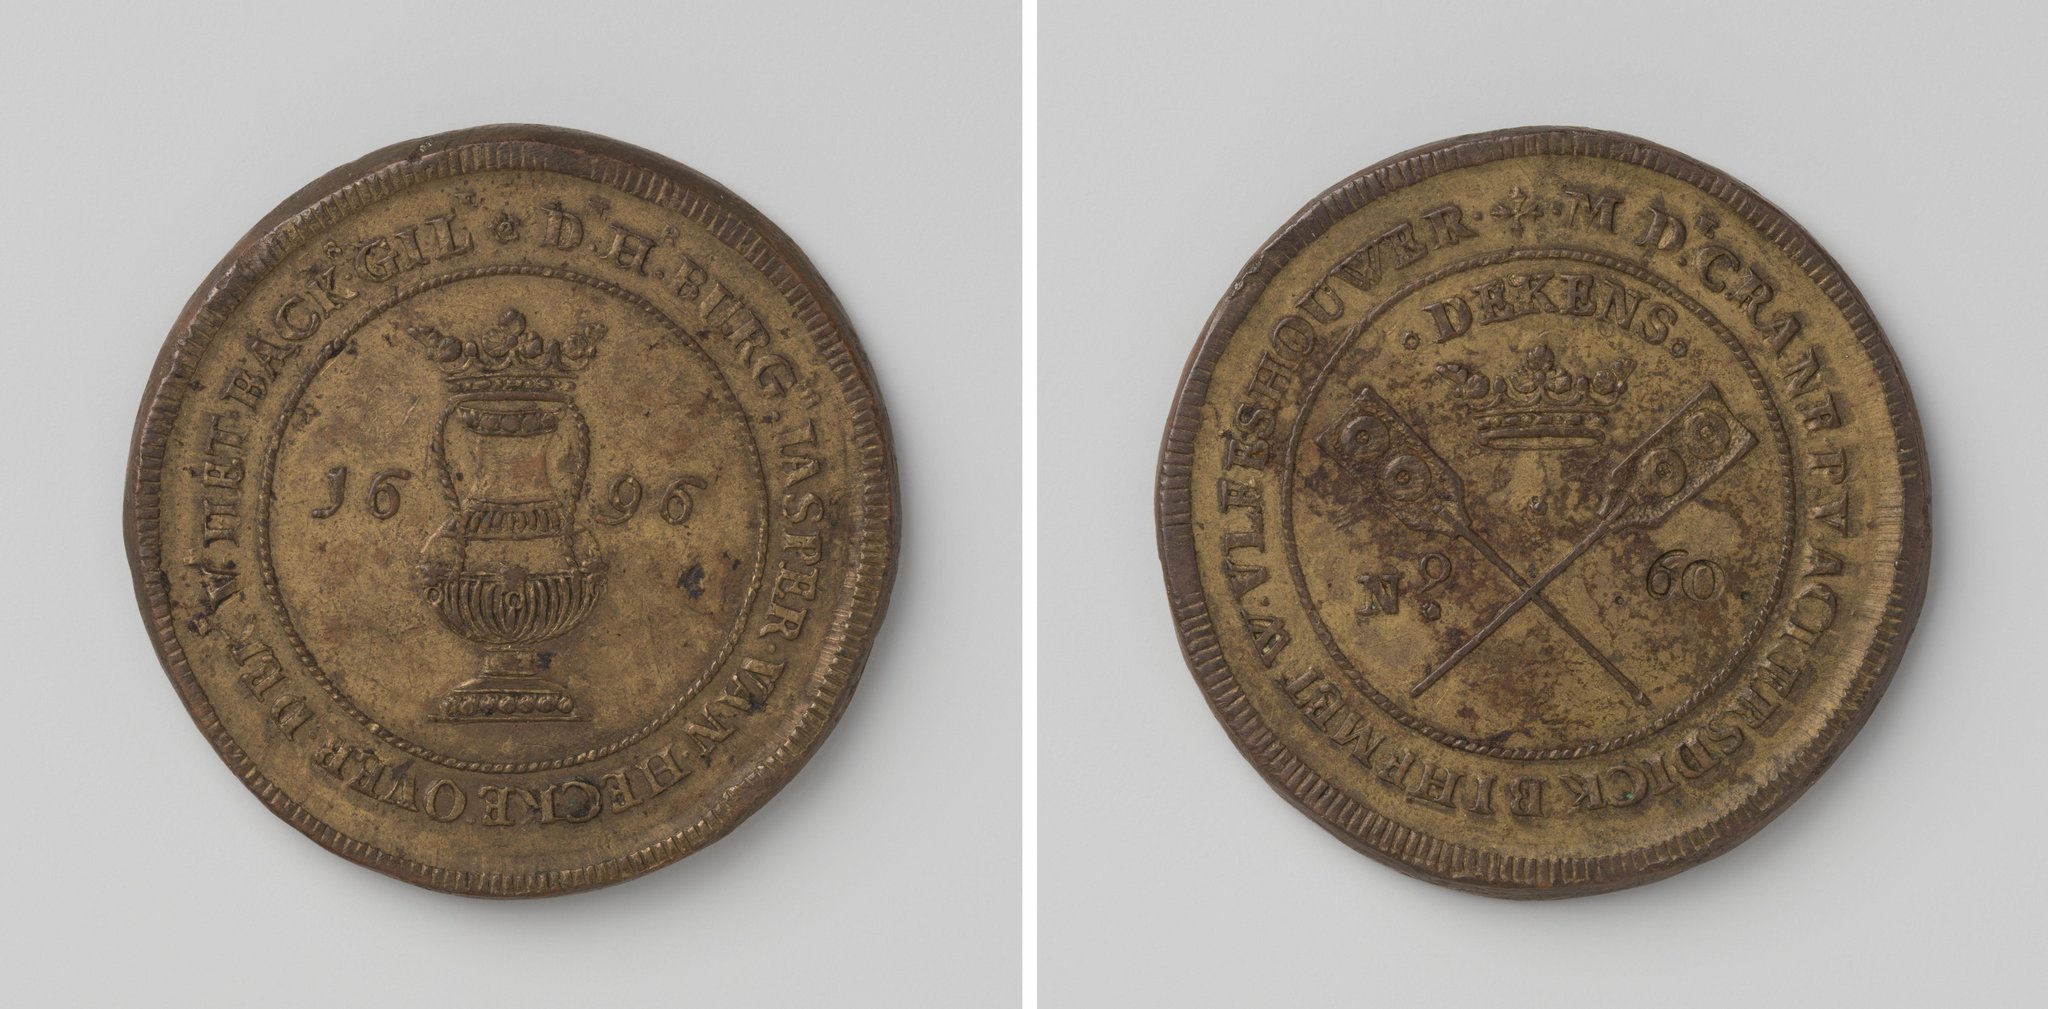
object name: medal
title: Bakkersgilde van Vlissingen, gildepenning met no. 60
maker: Anonymous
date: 1696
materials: brass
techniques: engraving, striking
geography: flushing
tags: flushing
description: Messing penning. Voorzijde: gekroonde fles tussen jaartal binnen omschrift. Keerzijde: twee kruislings geplaatste bakkersschoten onder kroon en opschrift tussen cijfer No. 60 binnen omschrift